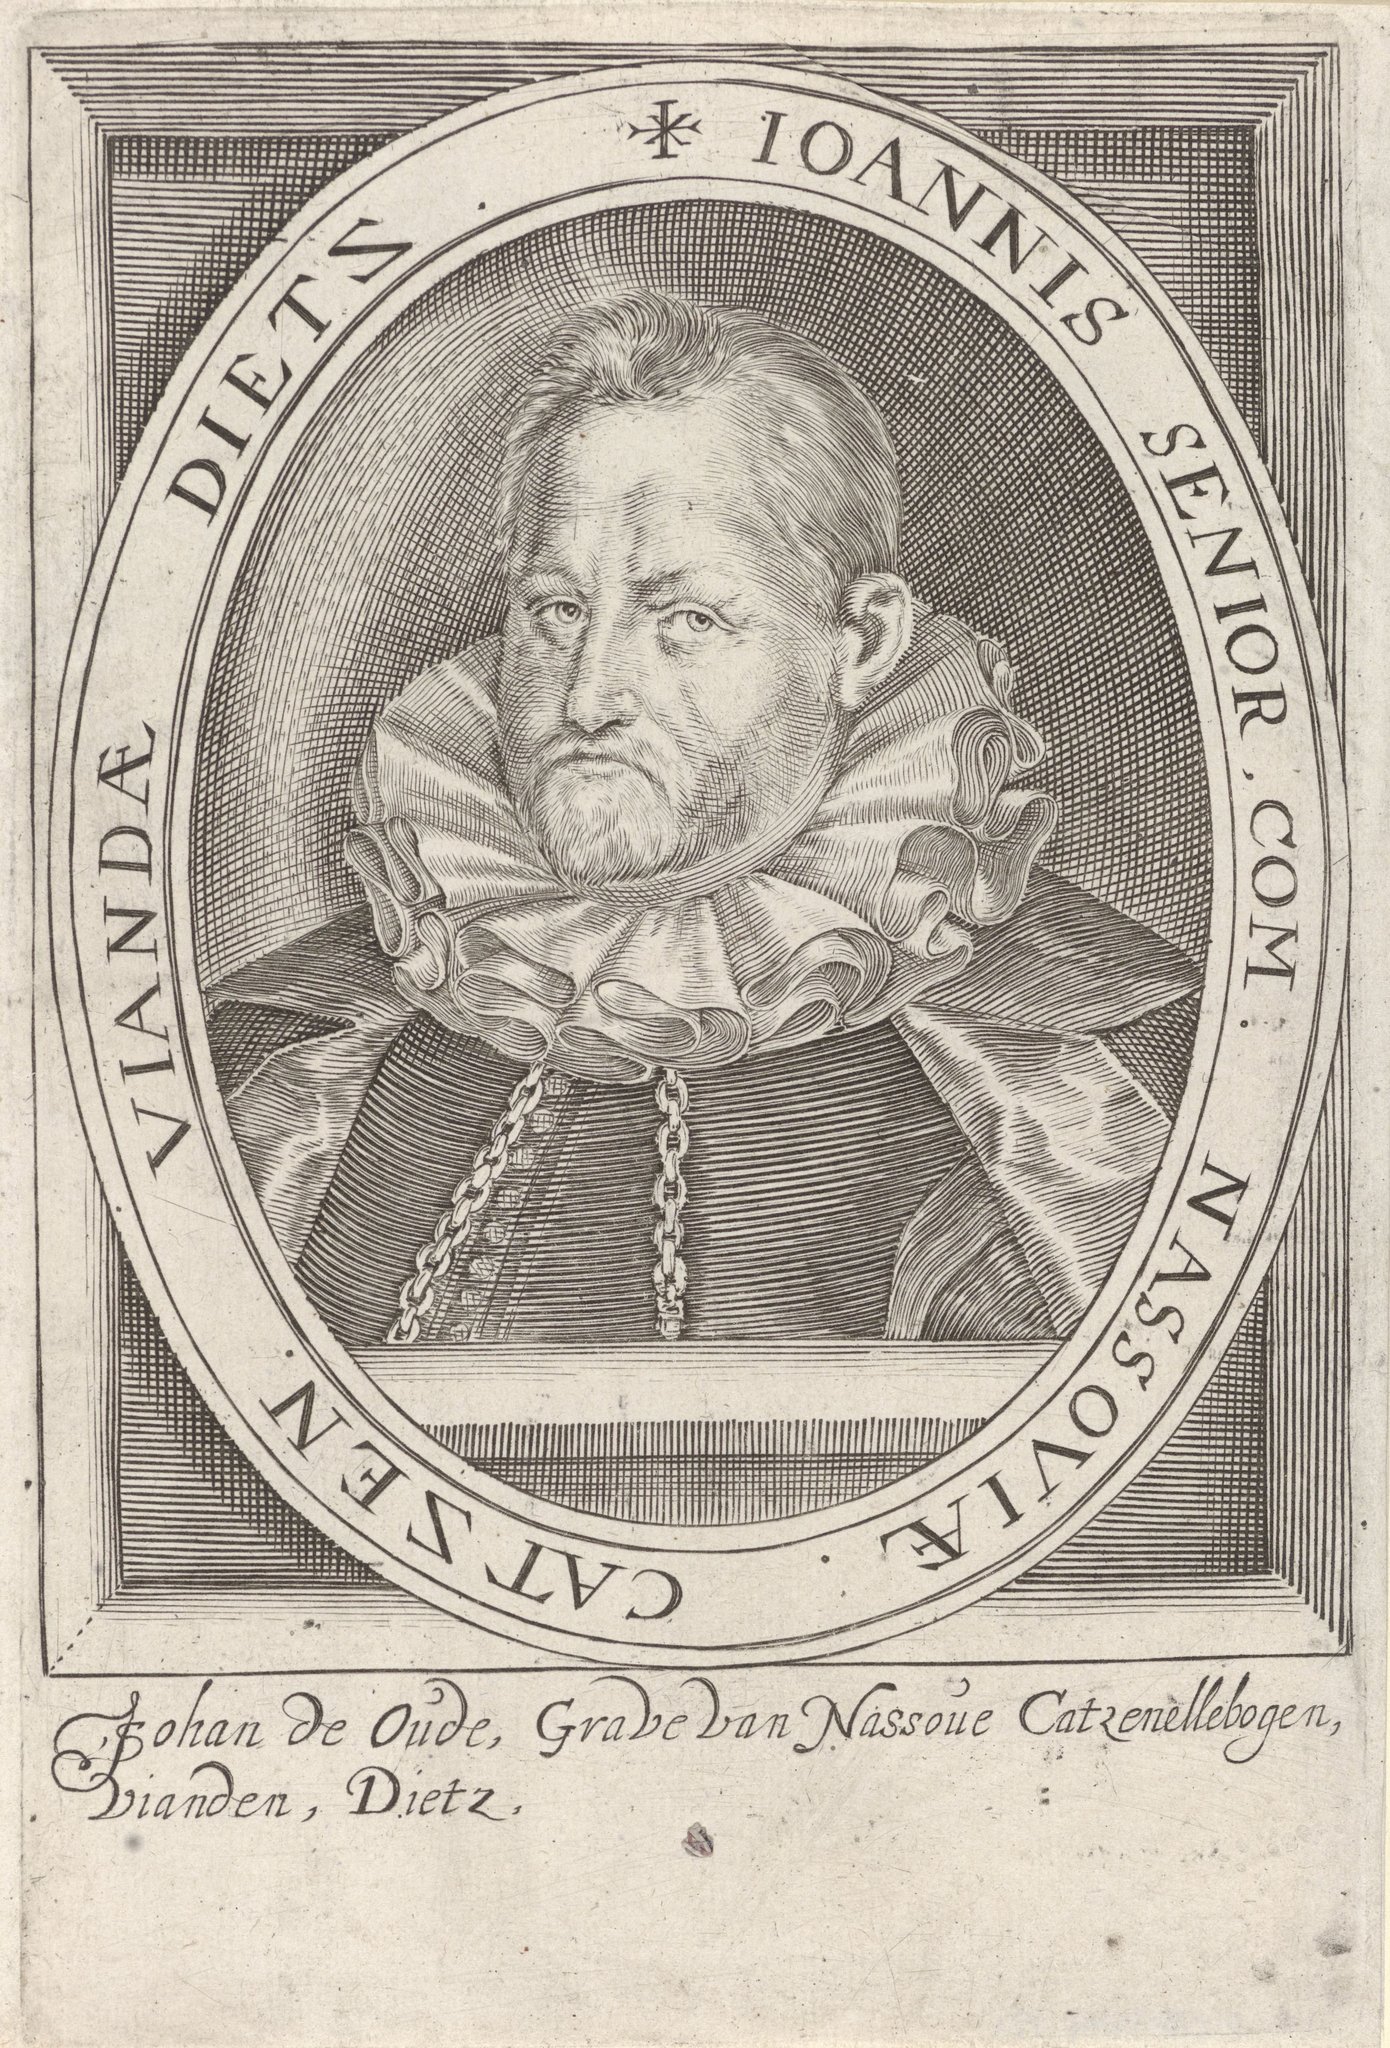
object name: print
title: Portret van Johan VI, graaf van Nassau-Dillenburg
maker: Anonymous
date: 1600-1699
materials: paper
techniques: engraving, etching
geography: low countries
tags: dillenburg, stadhouder, johan vi graaf van nassau-dillenburg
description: De hier vermelde titel verwijst naar de hoogst verkregen titel van de geportretteerde, niet per se naar de titel die de geportretteerde op deze voorstelling draagt.